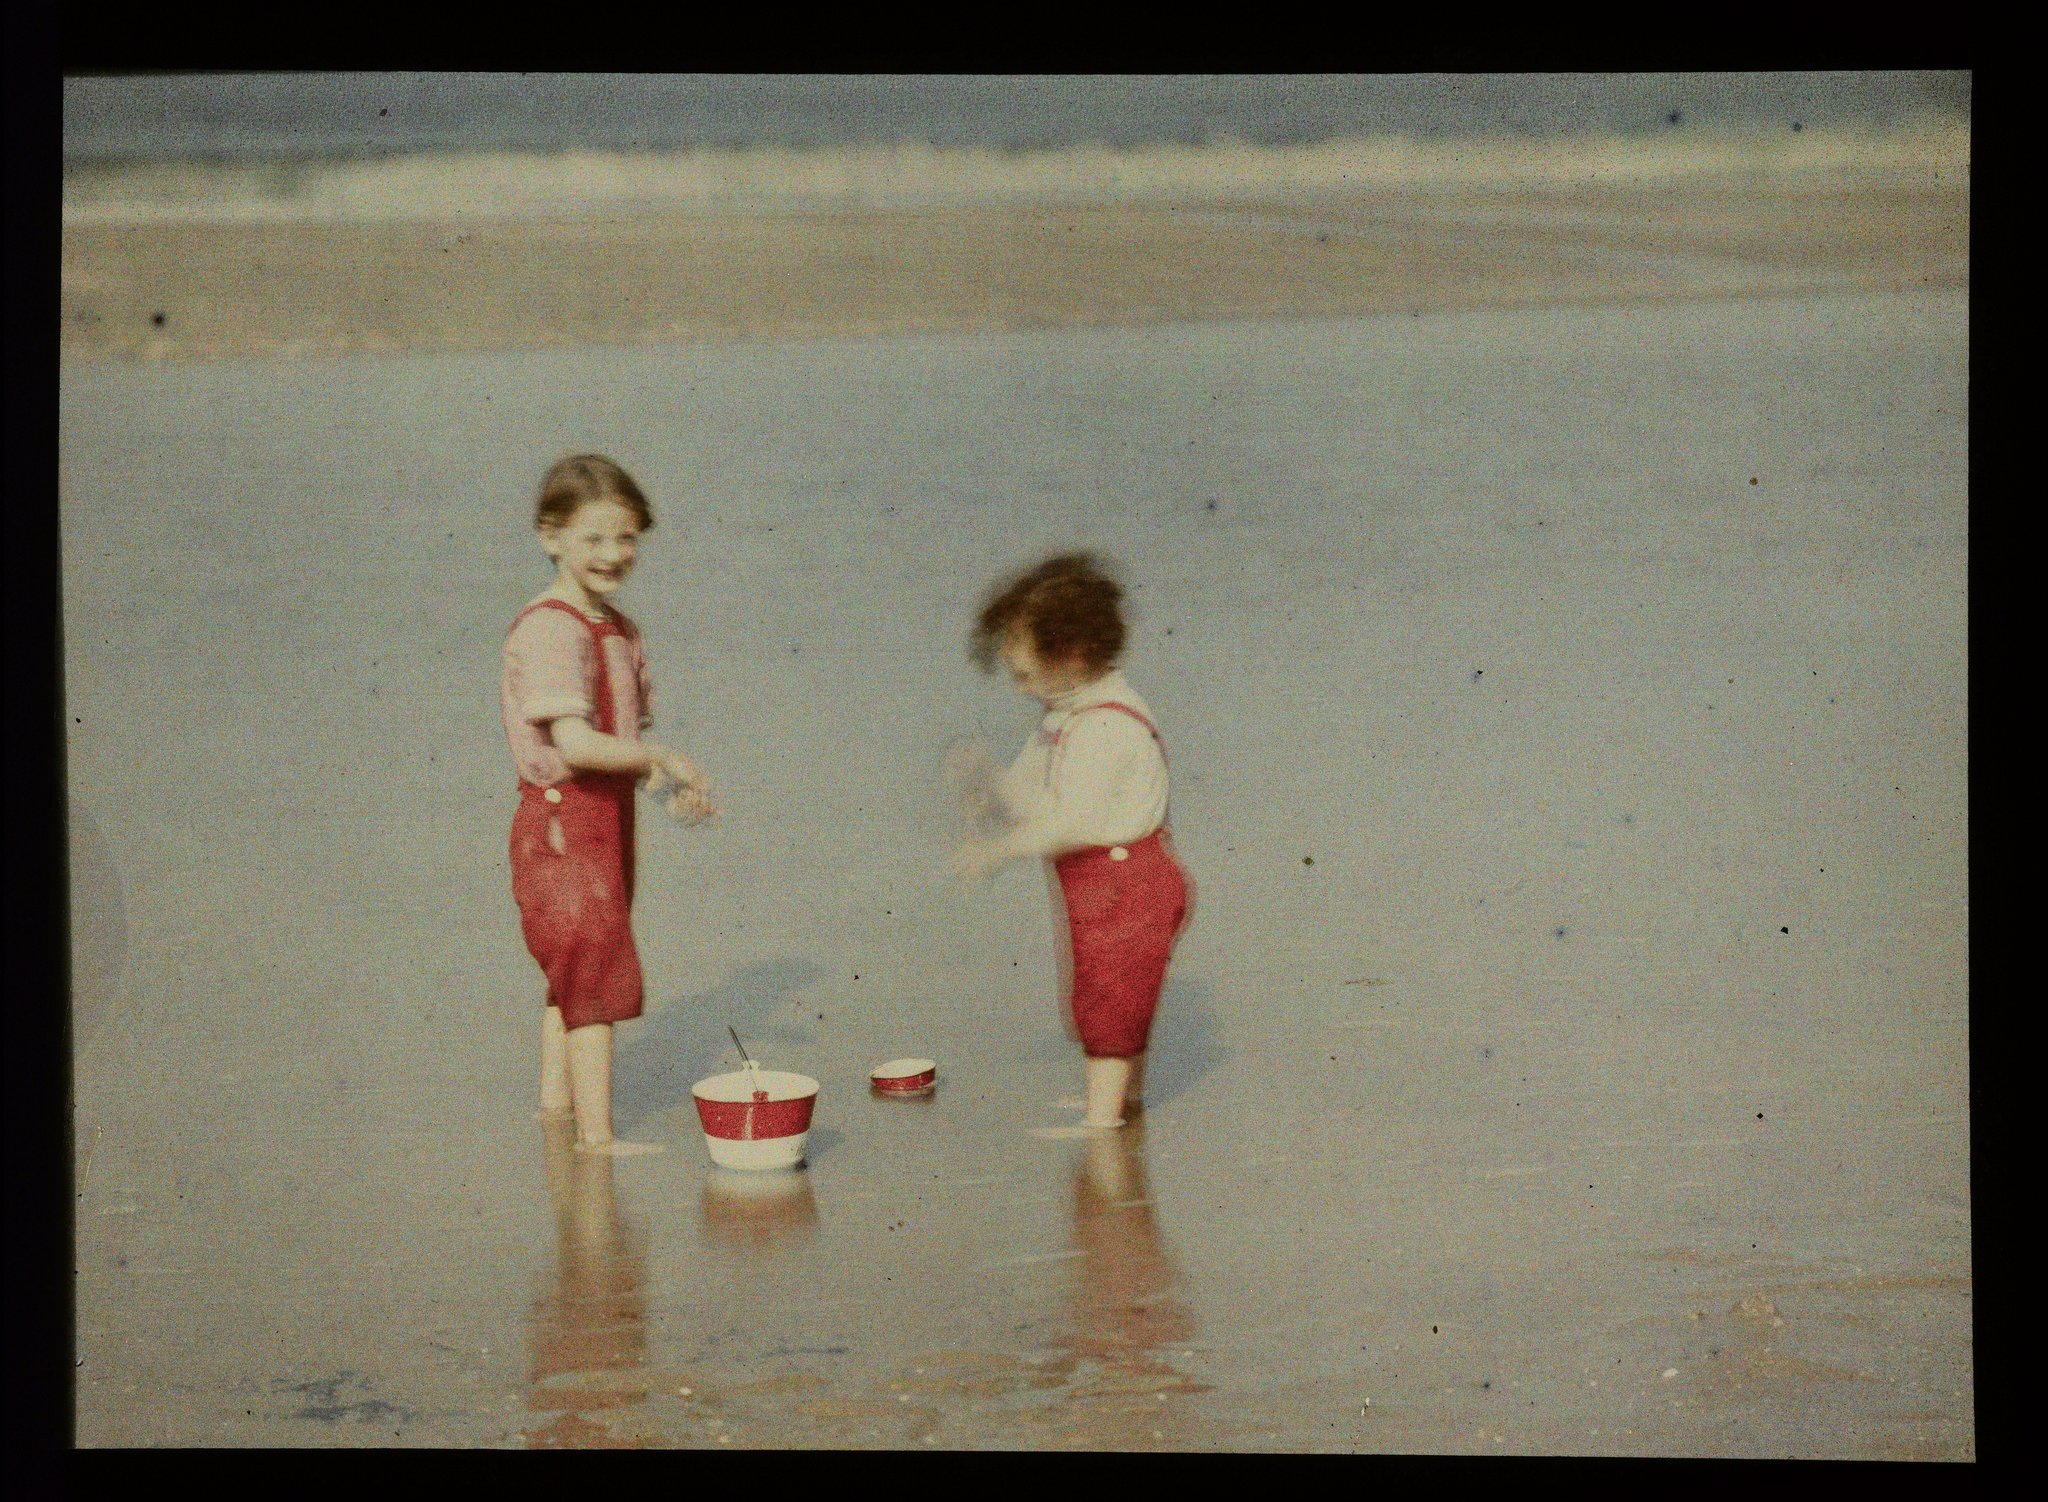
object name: color slide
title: Twee kinderen spelend aan het Noordzeestrand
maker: adolphe burdet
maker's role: fotograaf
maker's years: 1860-1940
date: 1907-1930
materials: glass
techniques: autochrome process, slide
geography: netherlands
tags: noordzee